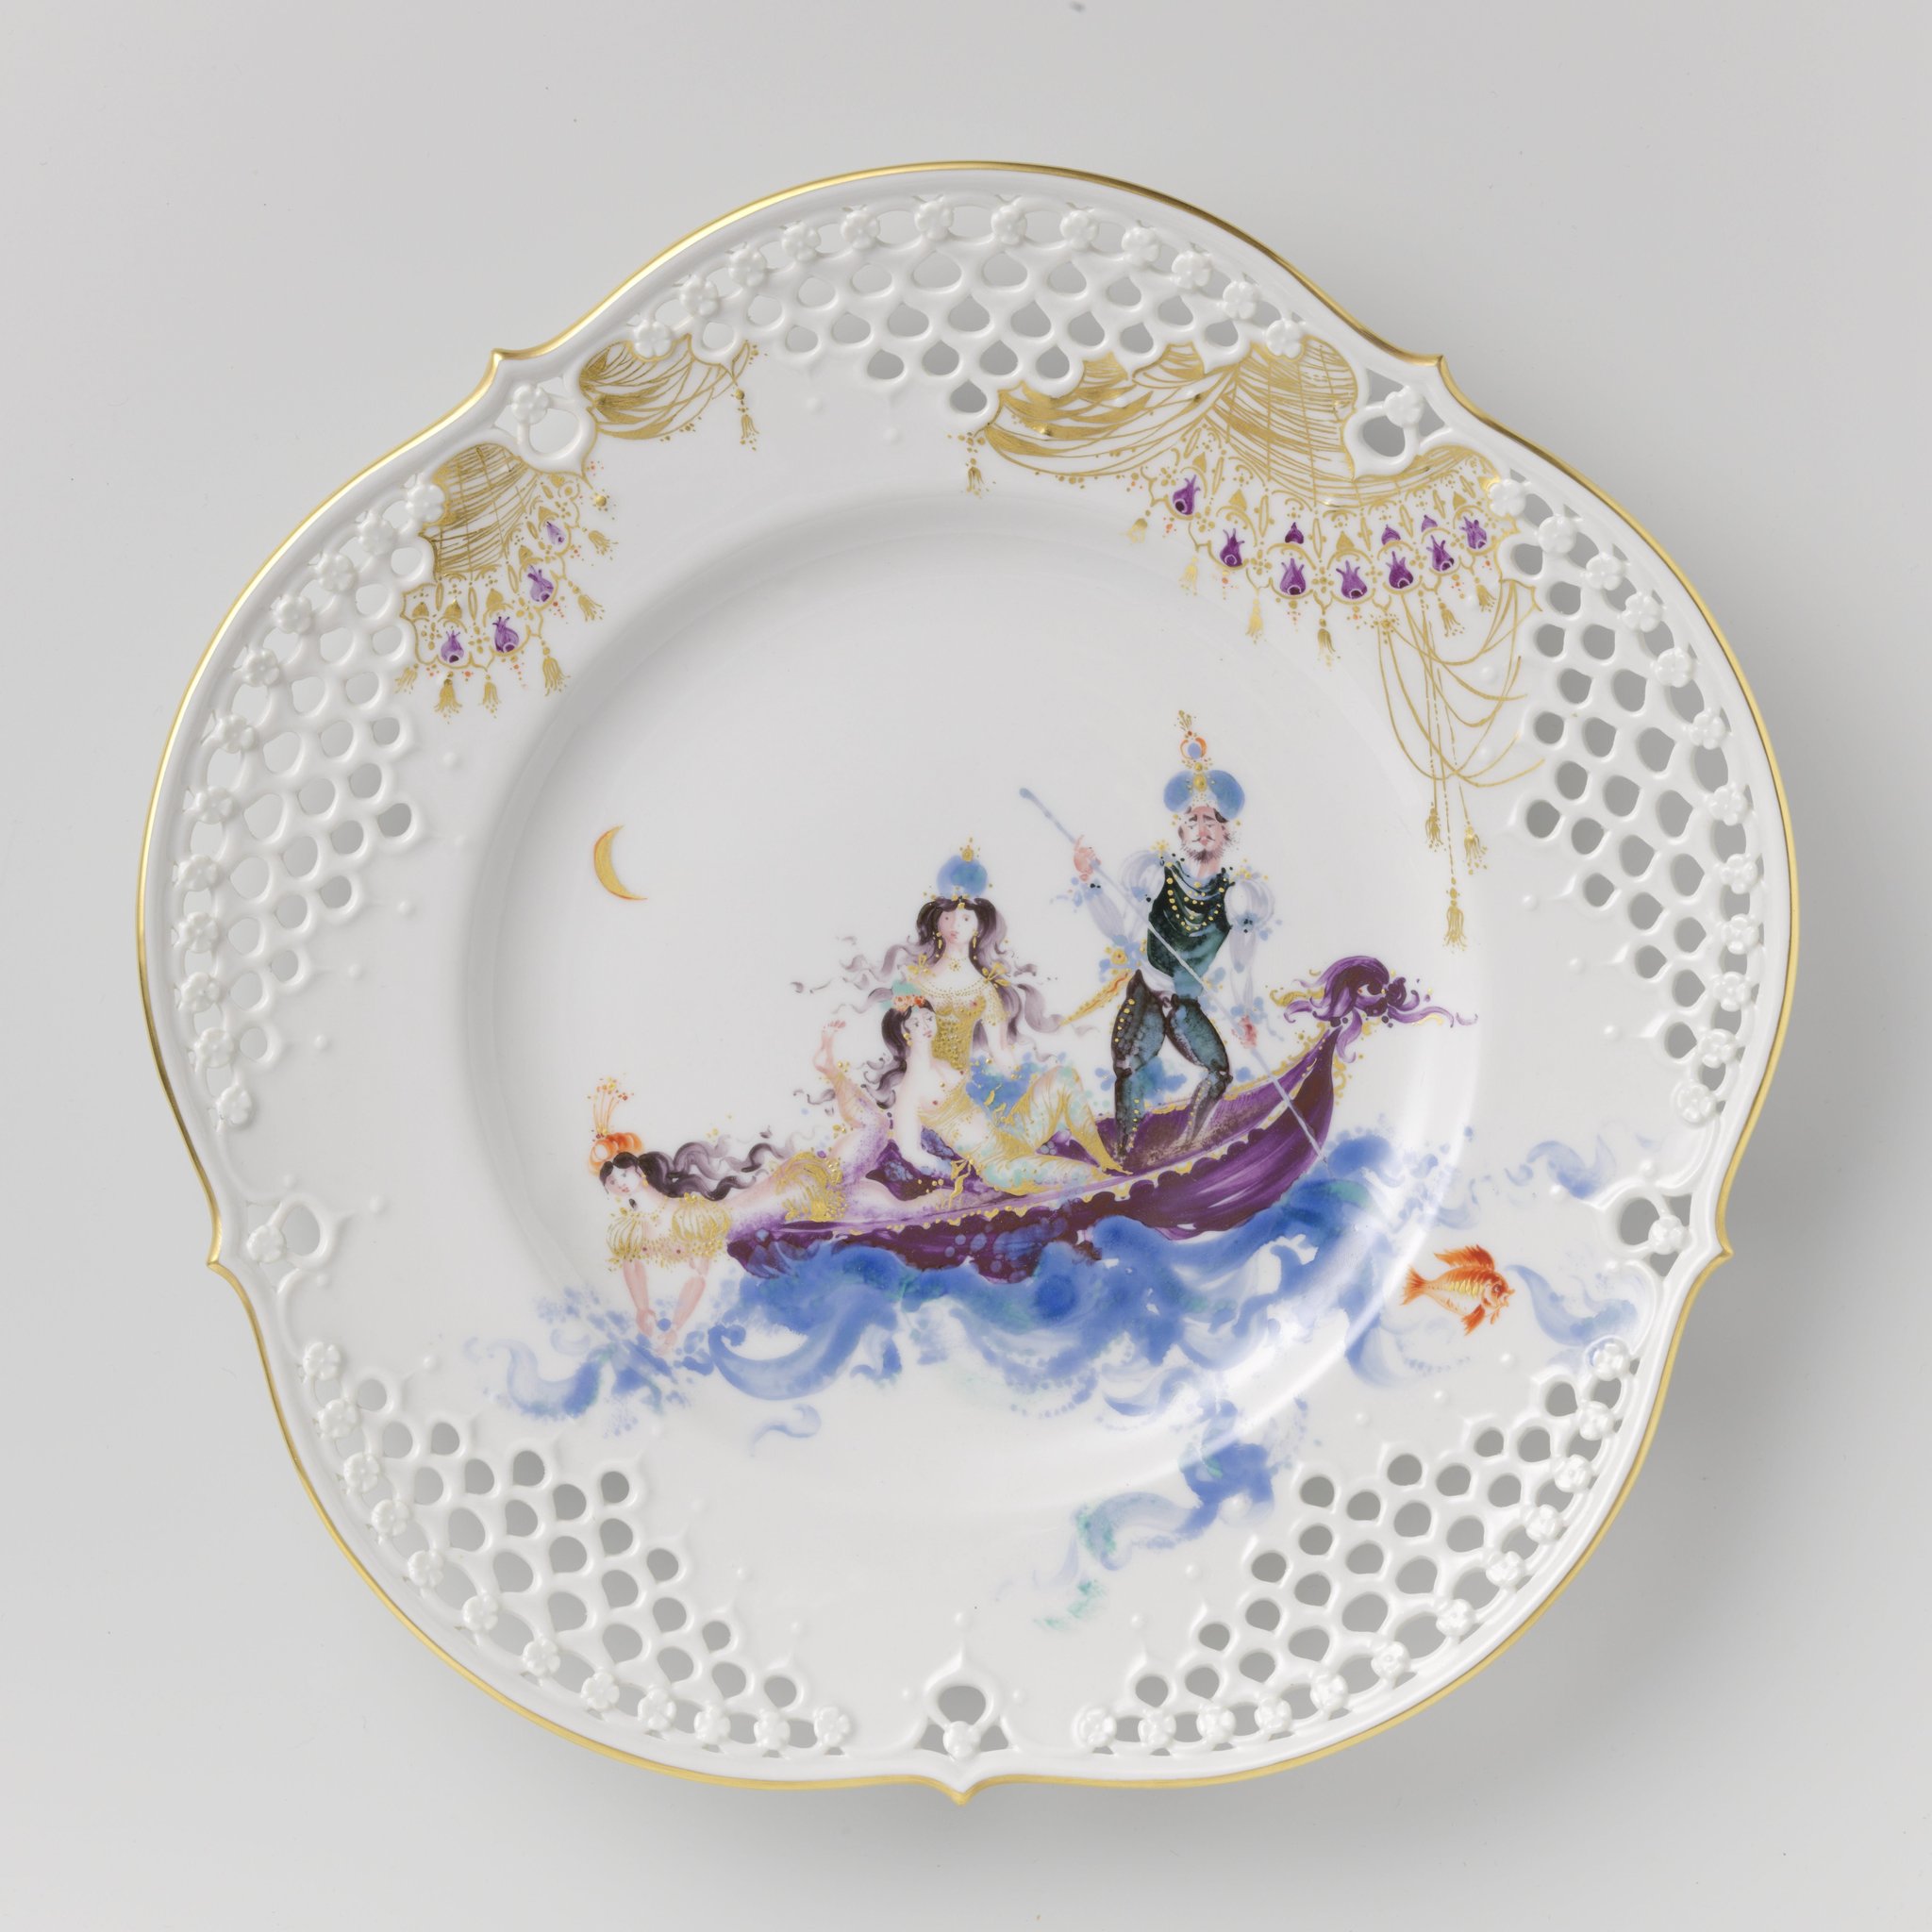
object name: dessert plate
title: Dessertbord, veelkleurig beschilderd met een voorstelling uit de vertellingen van Duizend-en-één-nacht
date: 1973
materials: porcelain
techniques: painted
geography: meissen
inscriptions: mark: ‘152 B’, factory mark: ‘twee gekruiste zwaarden’, mark: ‘5492’, inscription: ‘von der // Staatl. Porzellanmanufaktur Meissen // gewidmet // der Stadt Amsterdam und dem Rijksmuseum // November 1981’, mark, signature and date: ‘K. Teichmann // 81’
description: Dessertbord van beschilderd porselein. Het bord heeft een opengewerkte rand en is beschilderd met een voorstelling vartellingen van Duizend-en-één-nacht: vier vrouwen en een man in een boot. Het bord is gemerkt.